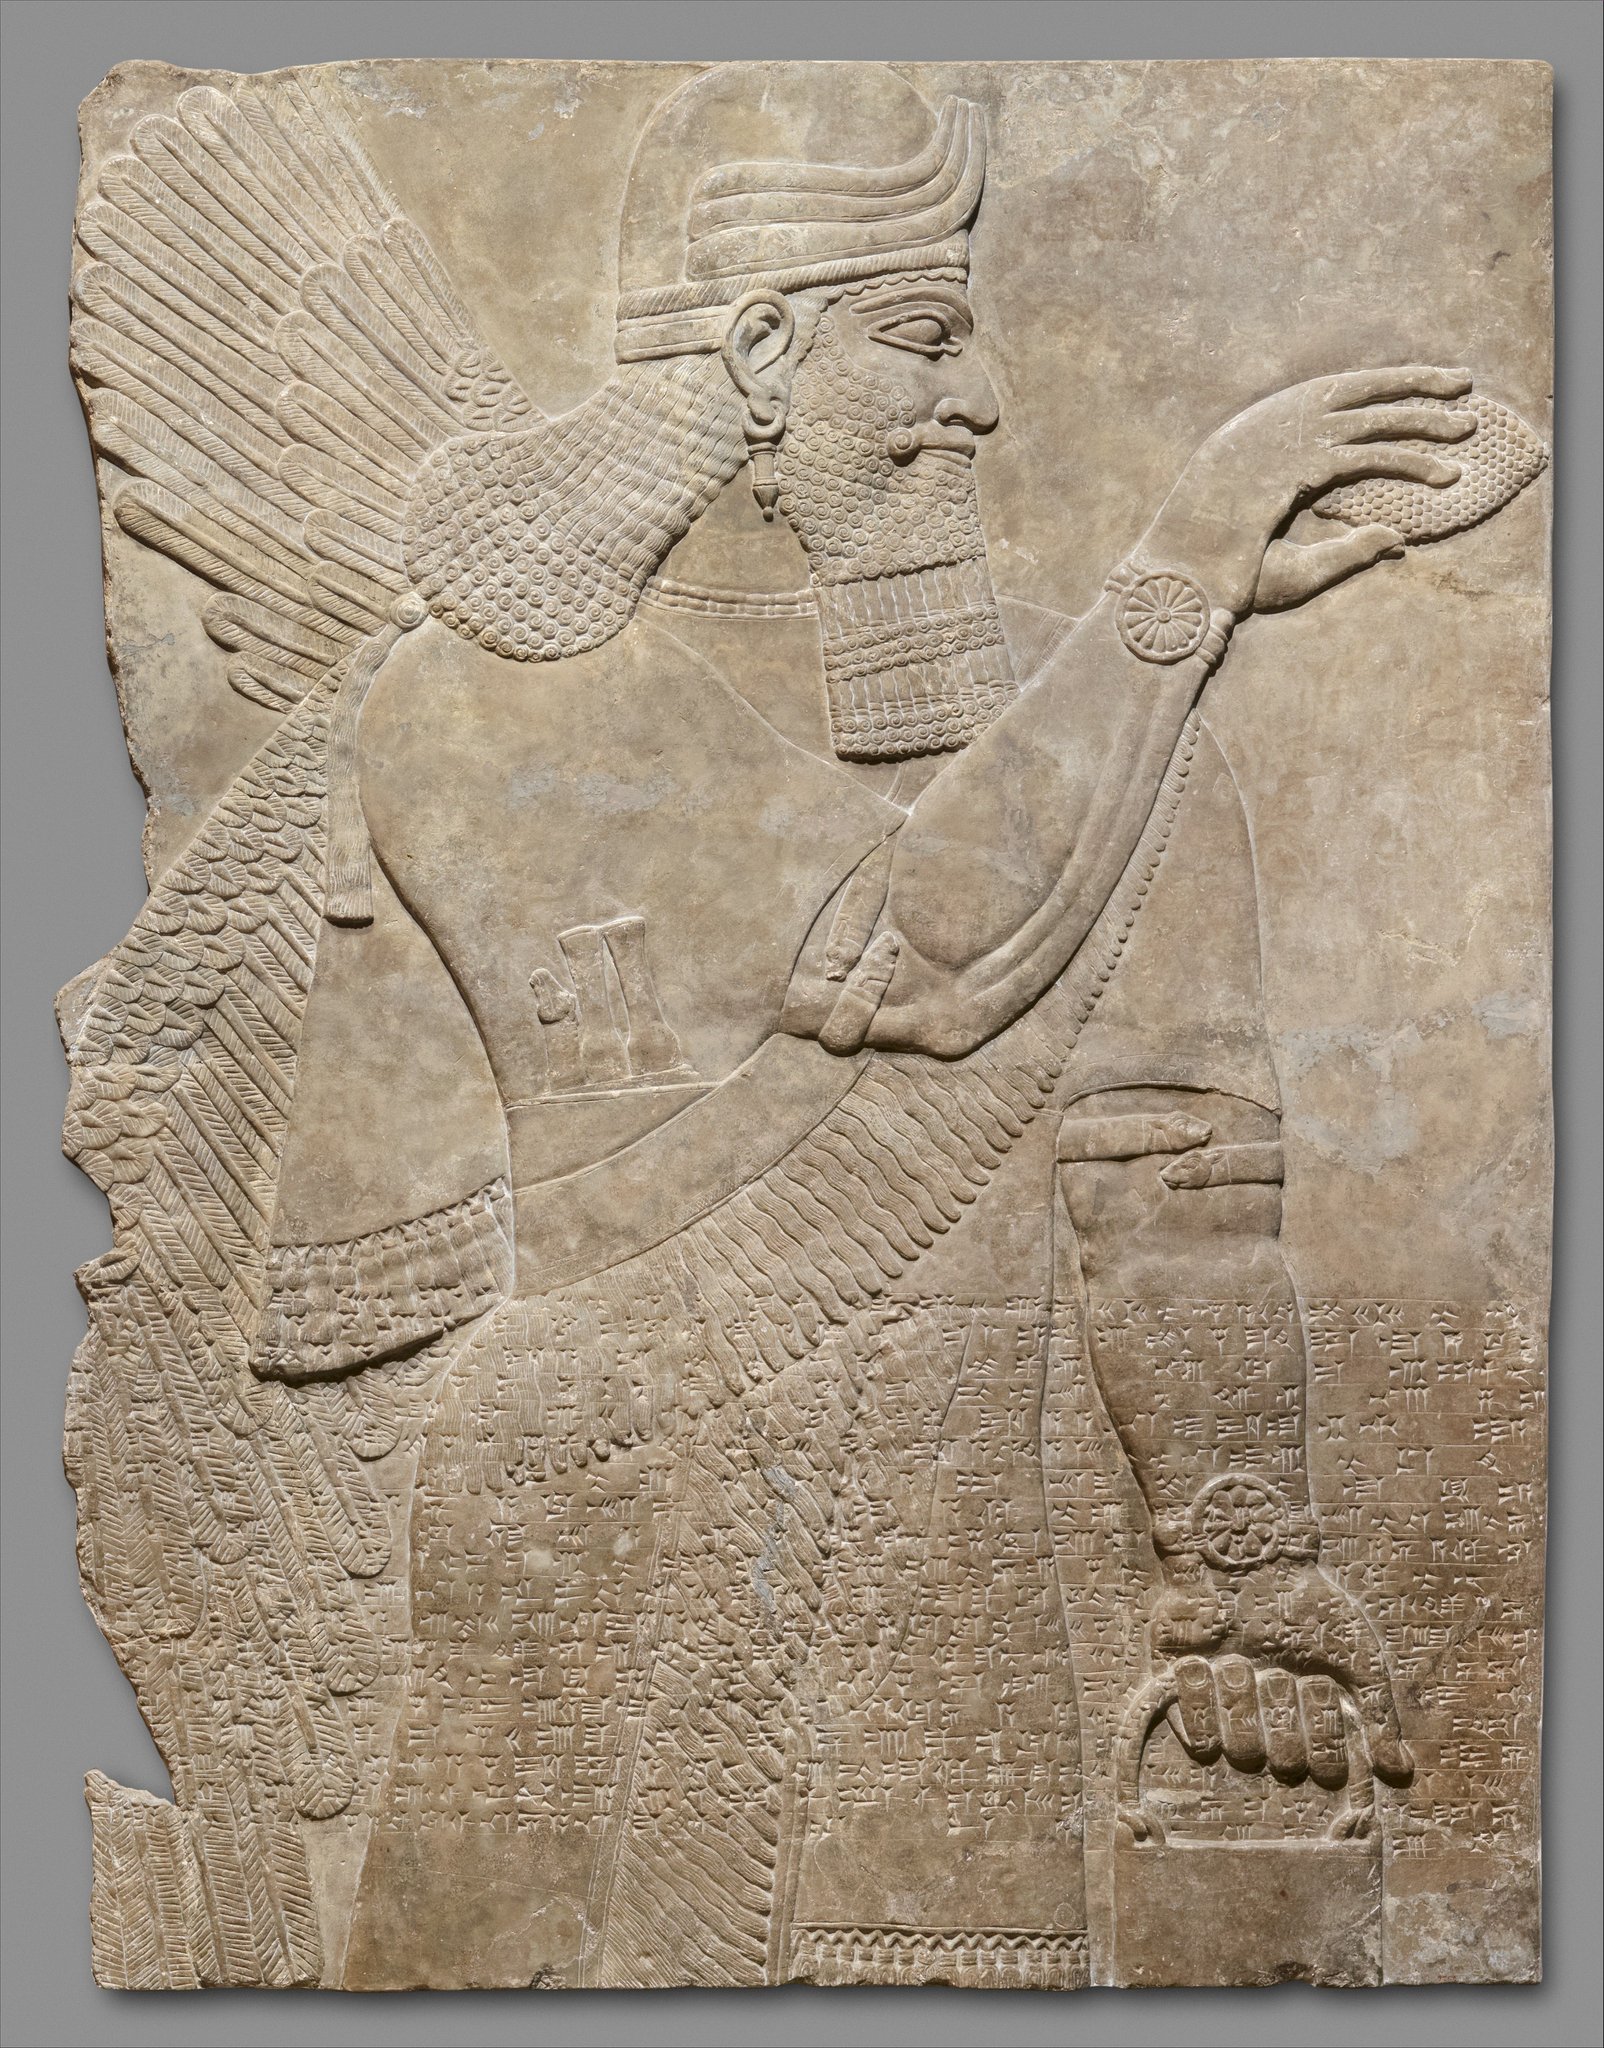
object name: relief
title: Relief panel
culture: assyrian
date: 883-859 BCE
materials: alabaster, gypsum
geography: mesopotamia